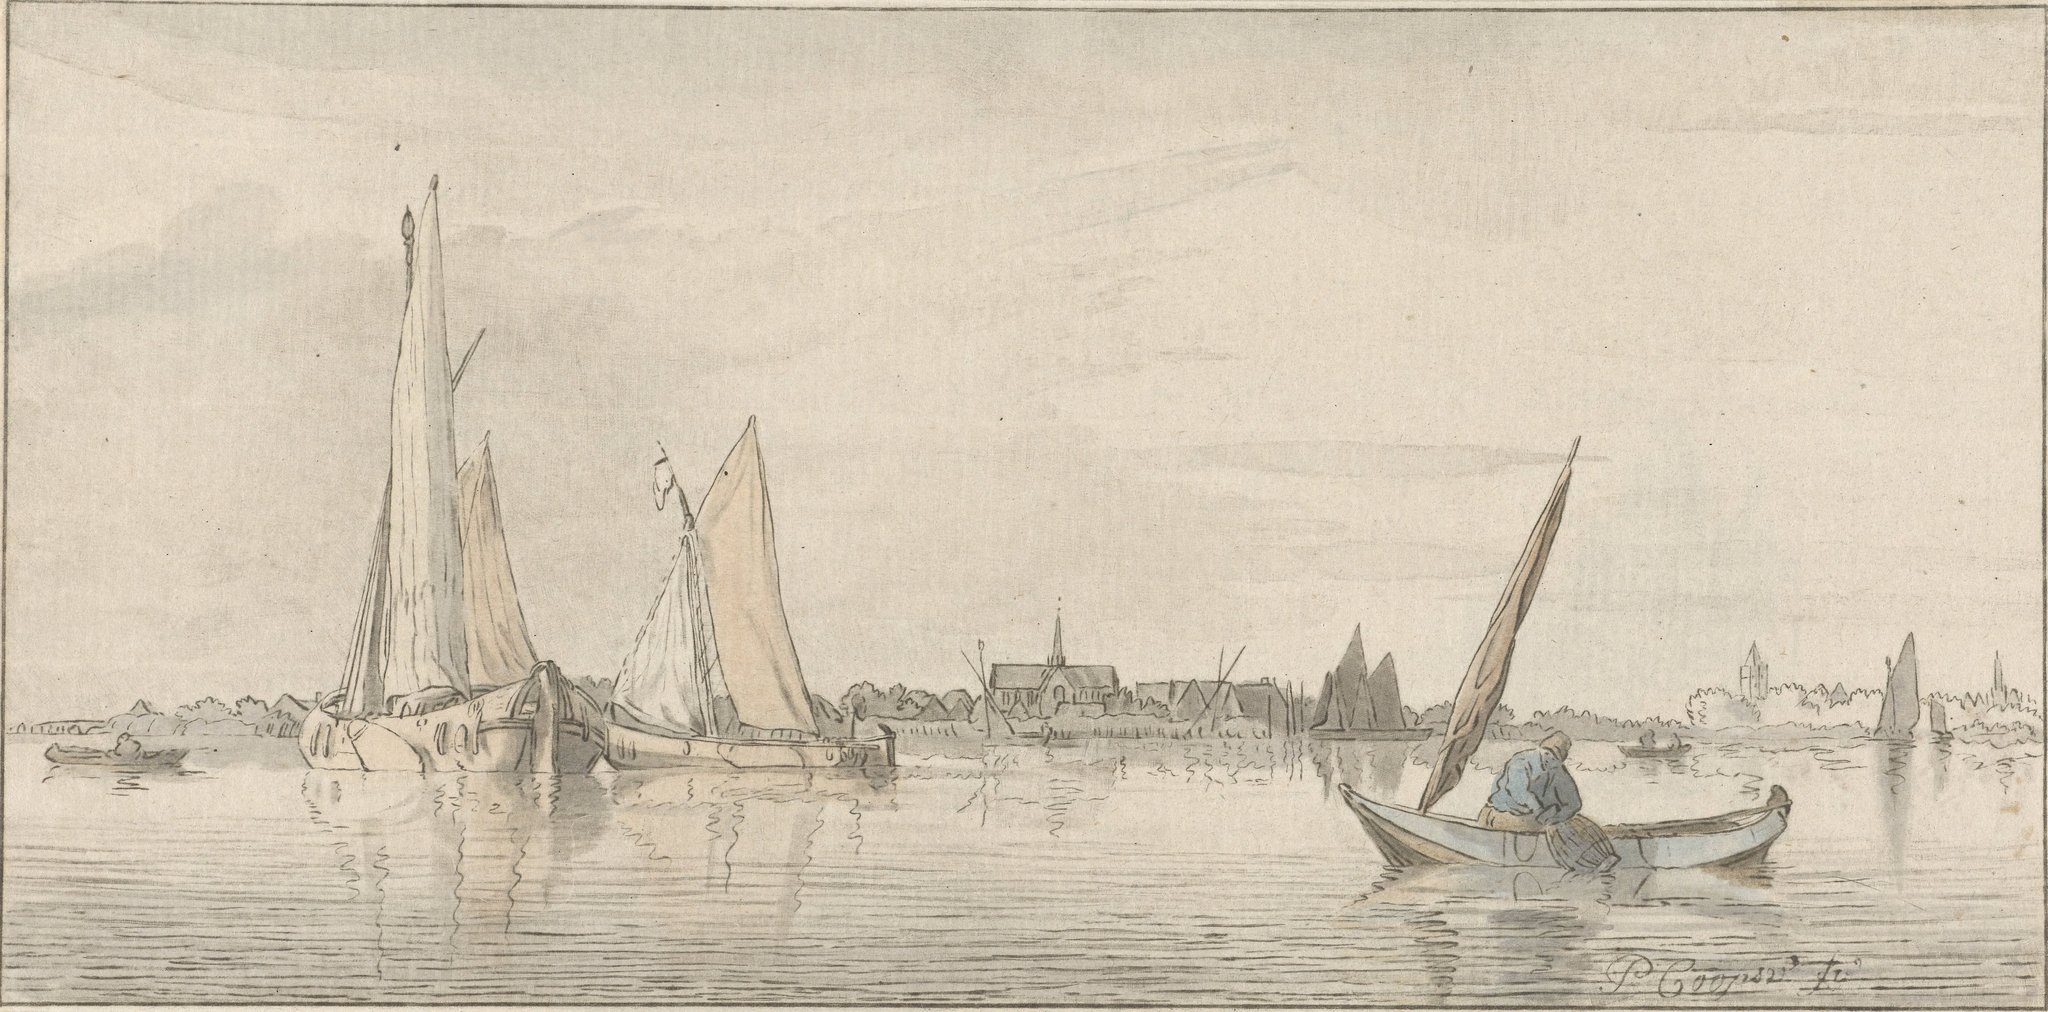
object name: print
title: Riviergezicht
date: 1775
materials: paper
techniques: etching, hand coloring, roulette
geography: amsterdam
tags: sailing-ship, sailing-boat, river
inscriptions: inscription: ‘P. Coops. del. Ploos van Amstel J.C. fecit. 1775.’, collector's mark: Lugt 240, collector's mark: Lugt 2725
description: Op het water varen zeilschepen. Aan de horizon een stad met een kerk.